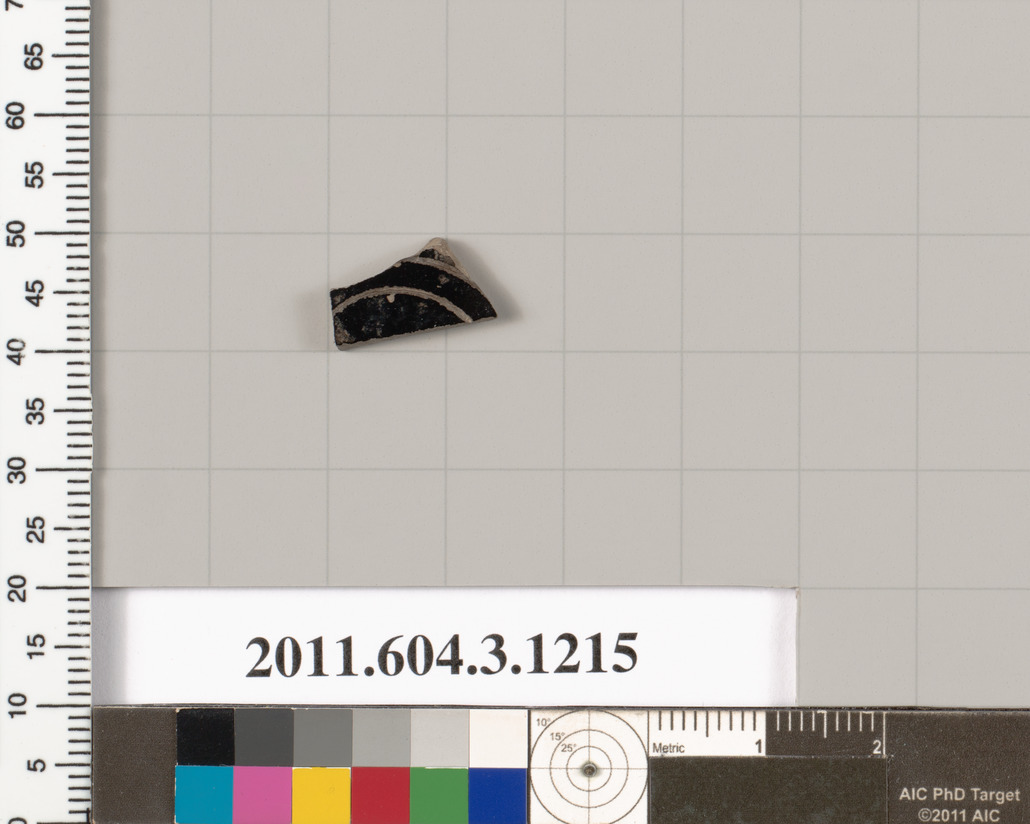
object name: mastoid or kyathos fragment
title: Terracotta fragment of a mastoid (drinking cup with narrow base) or a kyathos (cup-shaped ladle)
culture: greek, attic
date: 534-468 BCE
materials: terracotta